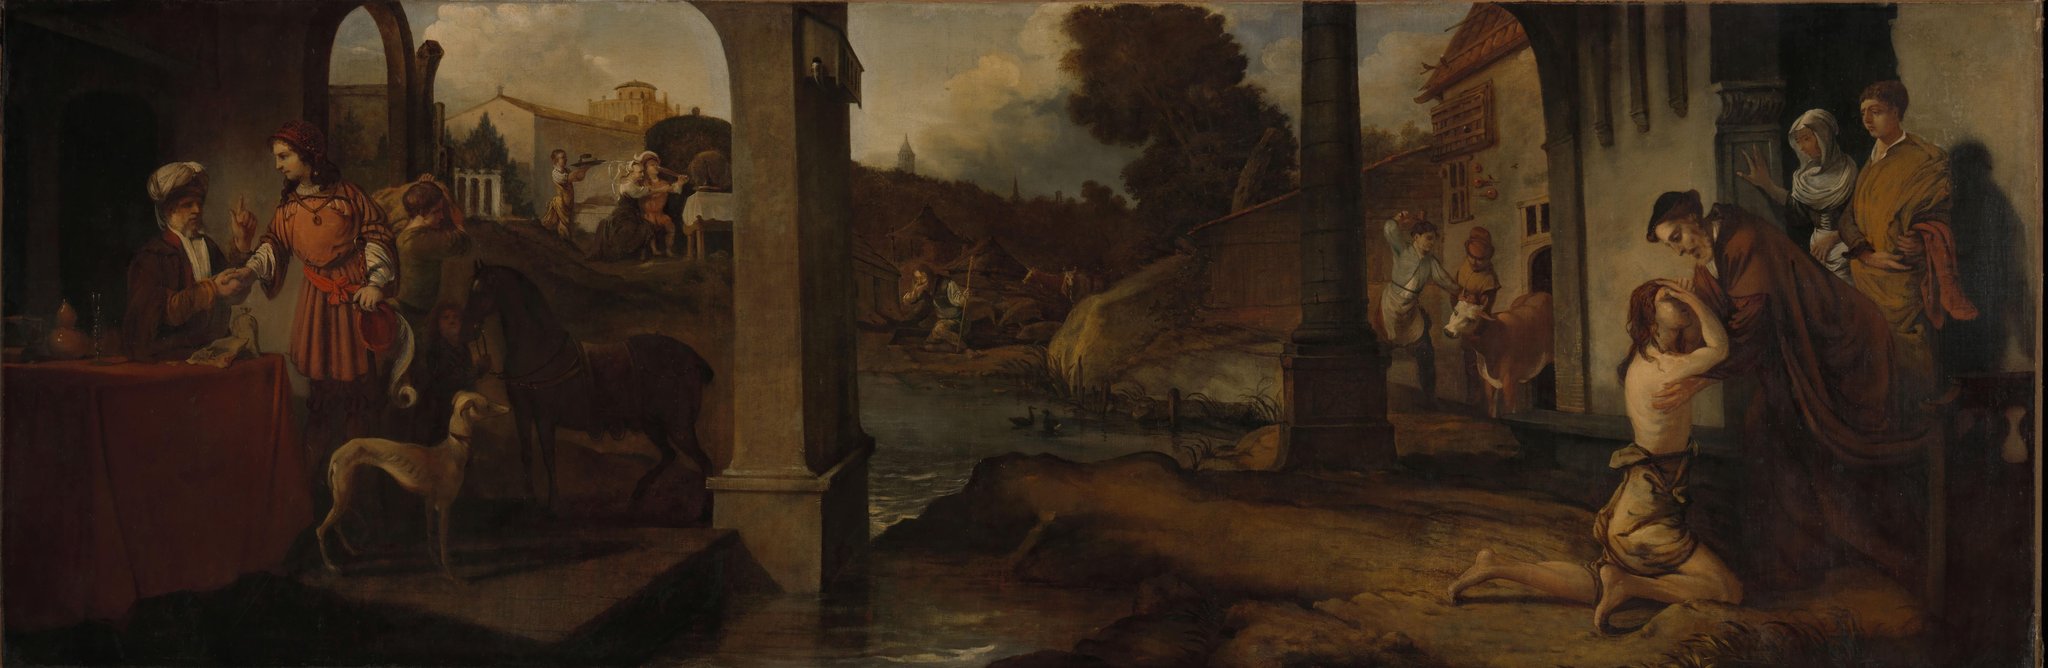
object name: painting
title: The Prodigal Son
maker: barent fabritius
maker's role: draughtsman, painter, print maker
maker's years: 1624-1673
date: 1661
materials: canvas, oil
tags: the prodigal son in the midst of prostitutes feasting and dissipating his patrimony, usually in a brothel or inn, the prodigal son returns home, where his father awaits him, the prodigal son tends the swine and eats from their trough, leave-taking and departure of the prodigal son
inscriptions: signature: ‘B. Fab...’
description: De verloren zoon. Het verhaal van de Verloren Zoon, uitgebeeld in vier taferelen op één schilderij. Links neemt de zoon afscheid van zijn vader, daarachter drinkt hij met een vrouw aan een tafel buiten een herberg. Rechts daarvan is de zoon als varkenshoeder te zien en uiterst rechts de thuiskomst van de zoon, het verwelkomen door de vader en het slachten van het gemeste kalf. Het doek maakt deel uit van een reeks van parabels geschilderd voor de Lutherse kerk in Leiden (zie ook nrs. SK-A-2959 en SK-A-2960).